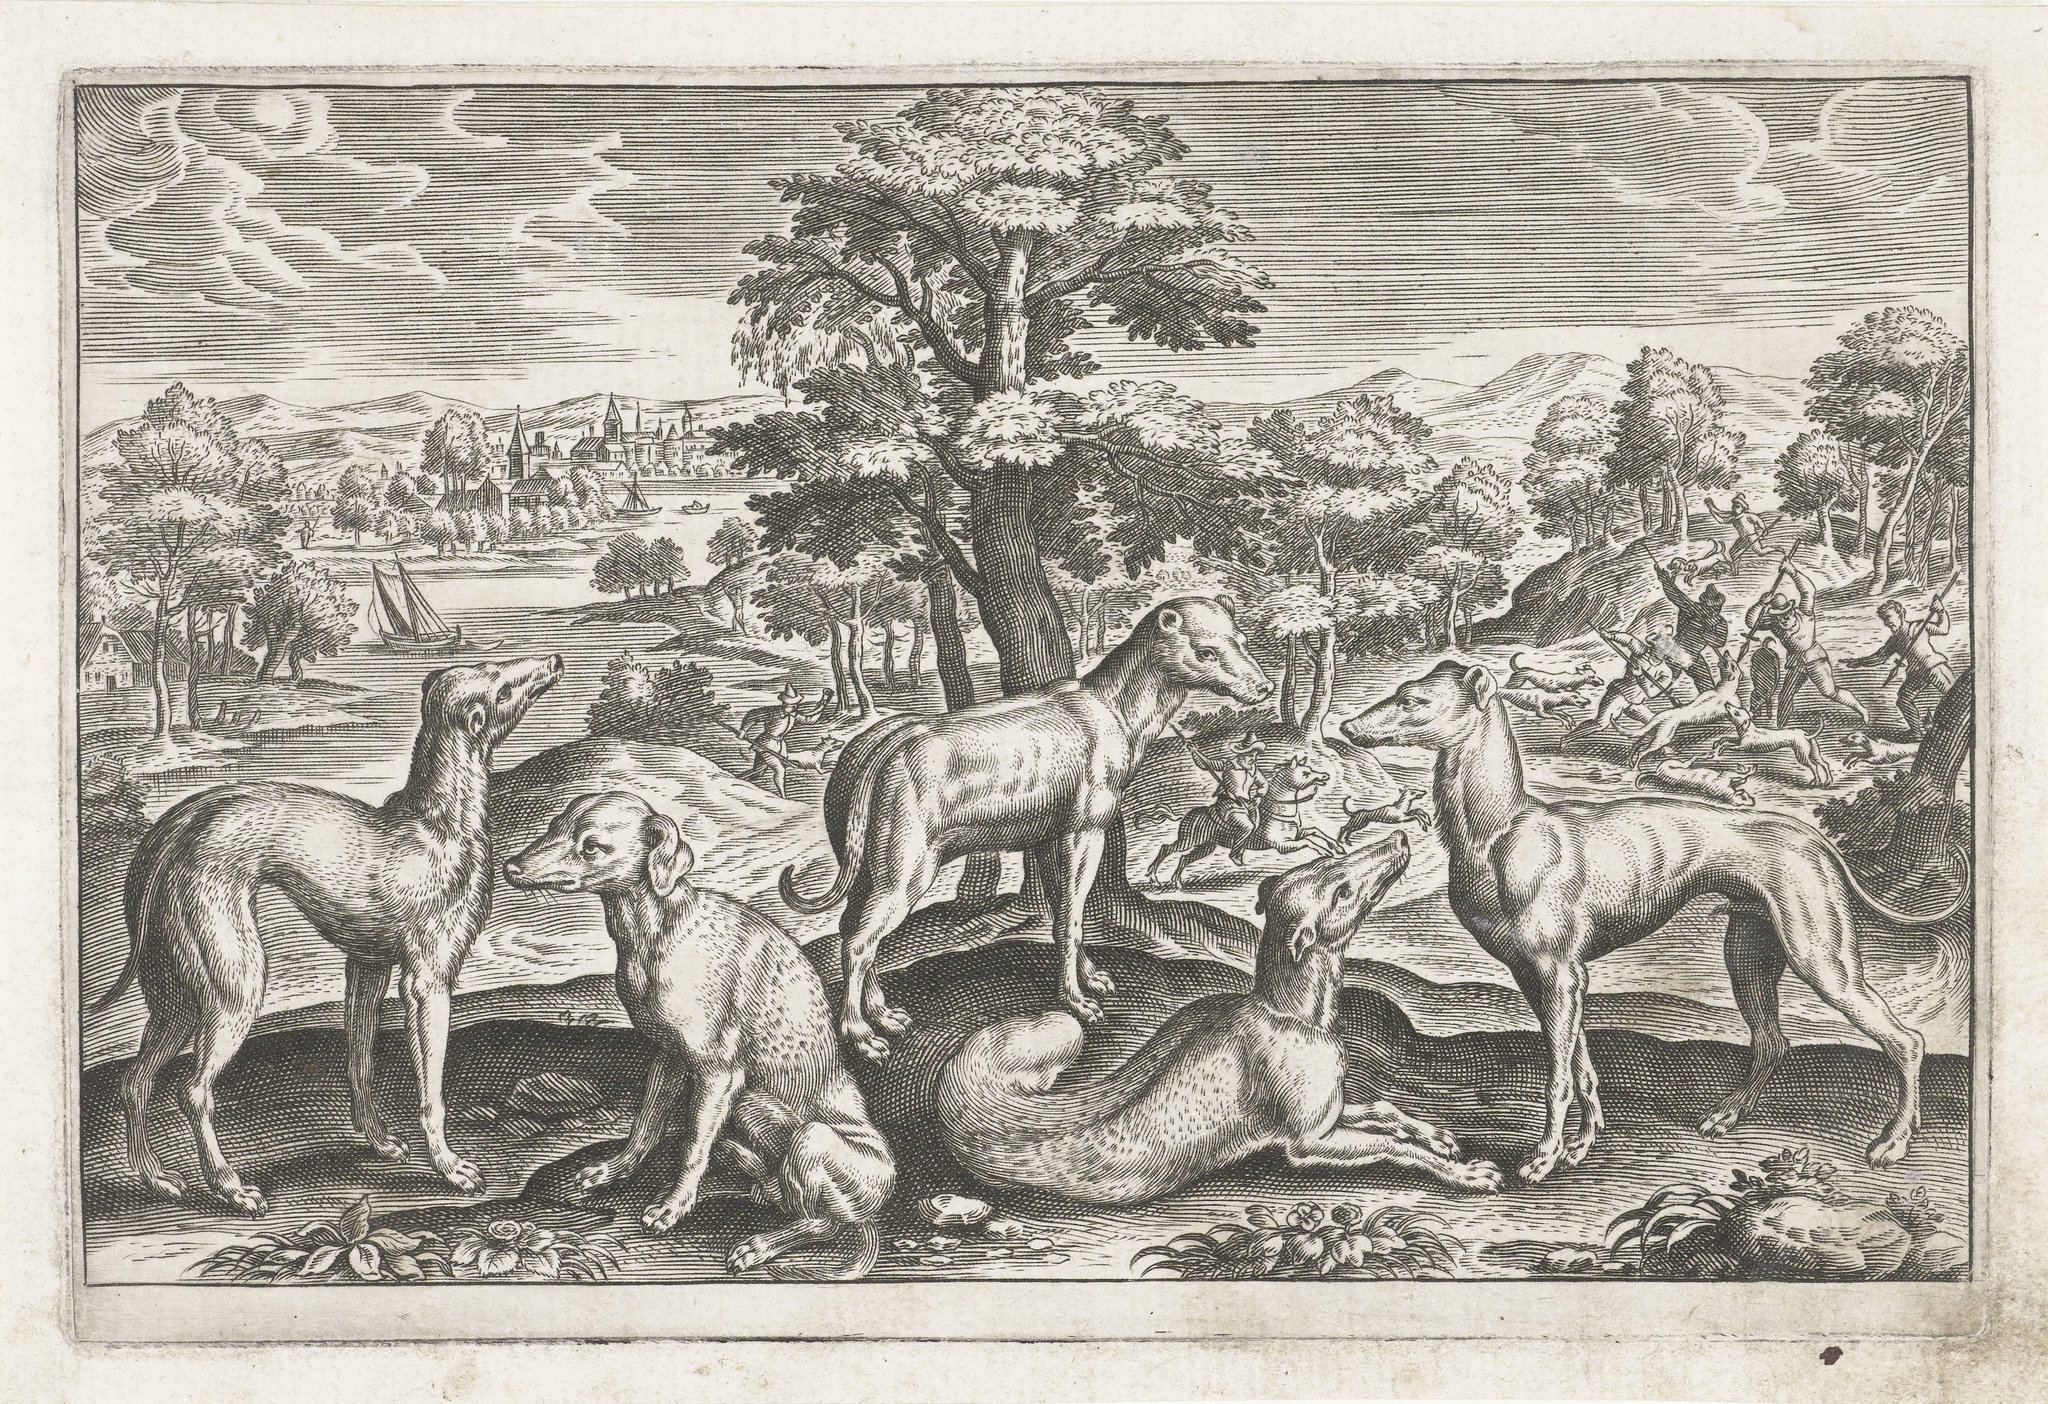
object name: print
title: Vierpotige dieren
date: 1595-1652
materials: paper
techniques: engraving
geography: amsterdam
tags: hunting dogs, river, hunt ~ predatory animals (fox, lion)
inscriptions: collector's mark: Lugt 2228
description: Op de voorgrond vijf jachthonden. Op de achtergrond een landschap met een rivier en een wolvenjacht. De prent maakt deel uit van een serie met dieren als onderwerp.